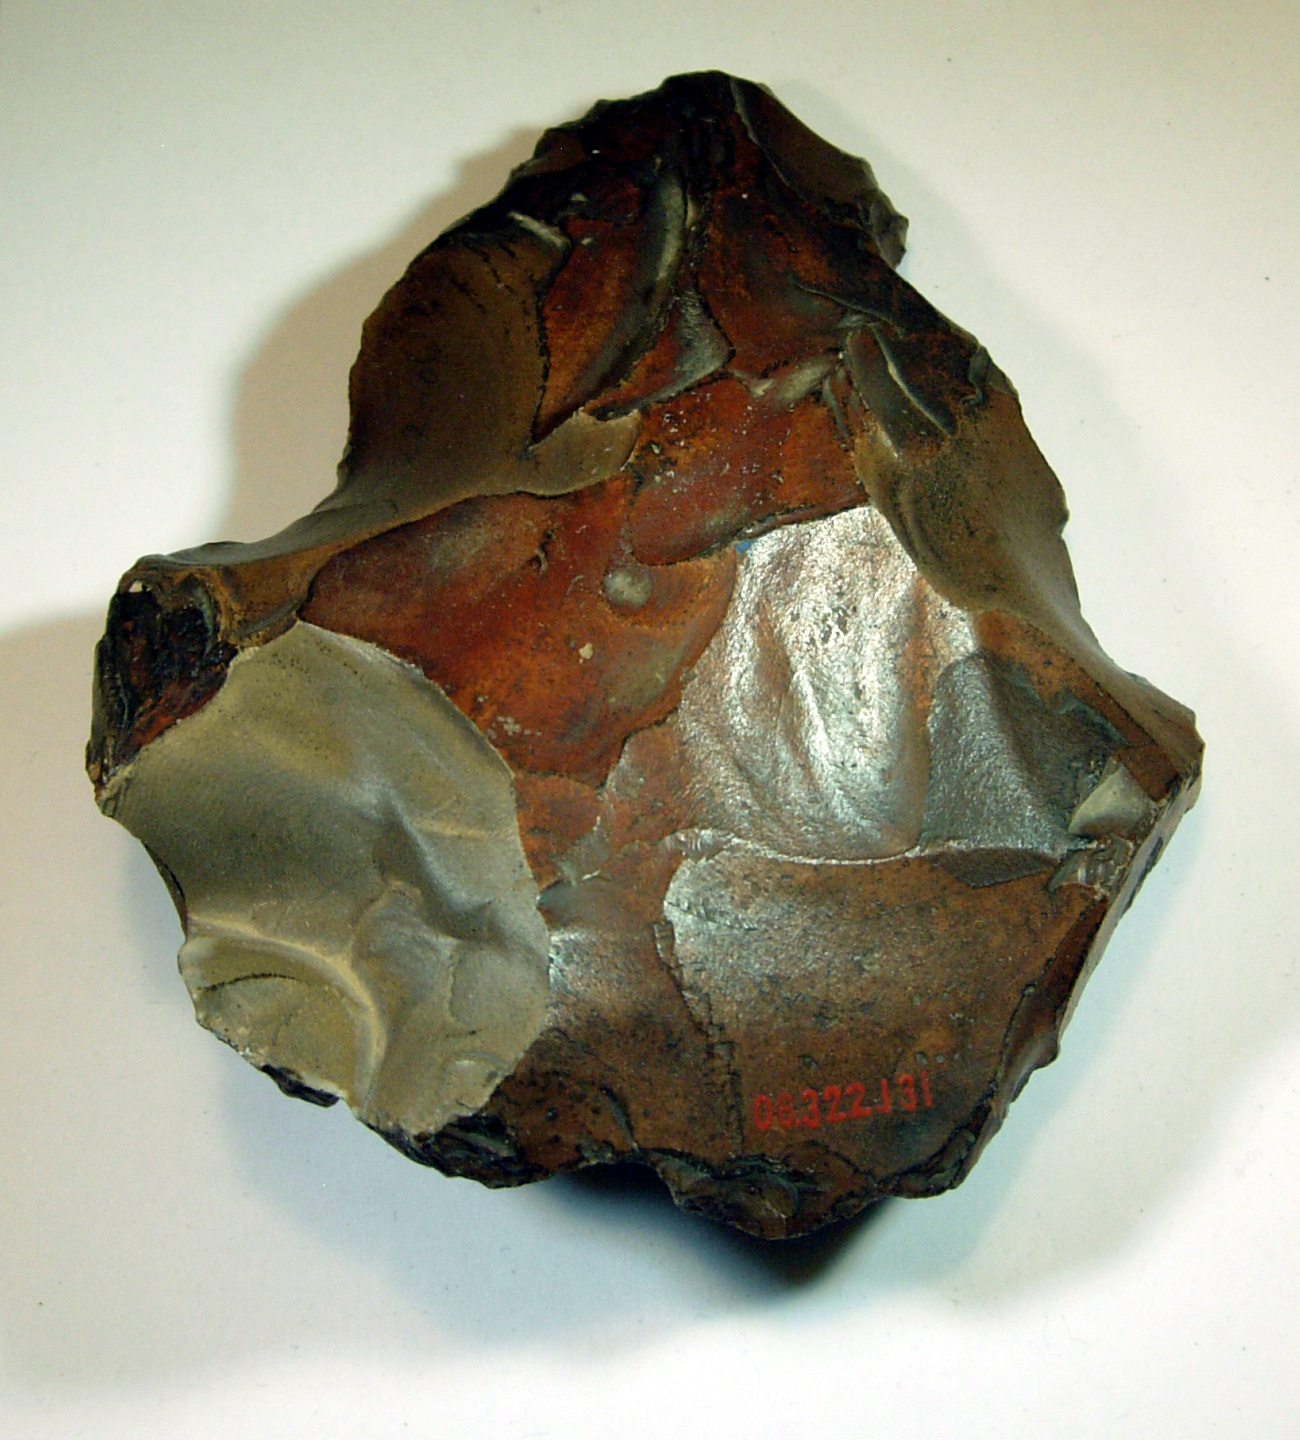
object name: tool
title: Tool (?)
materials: stone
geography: egypt